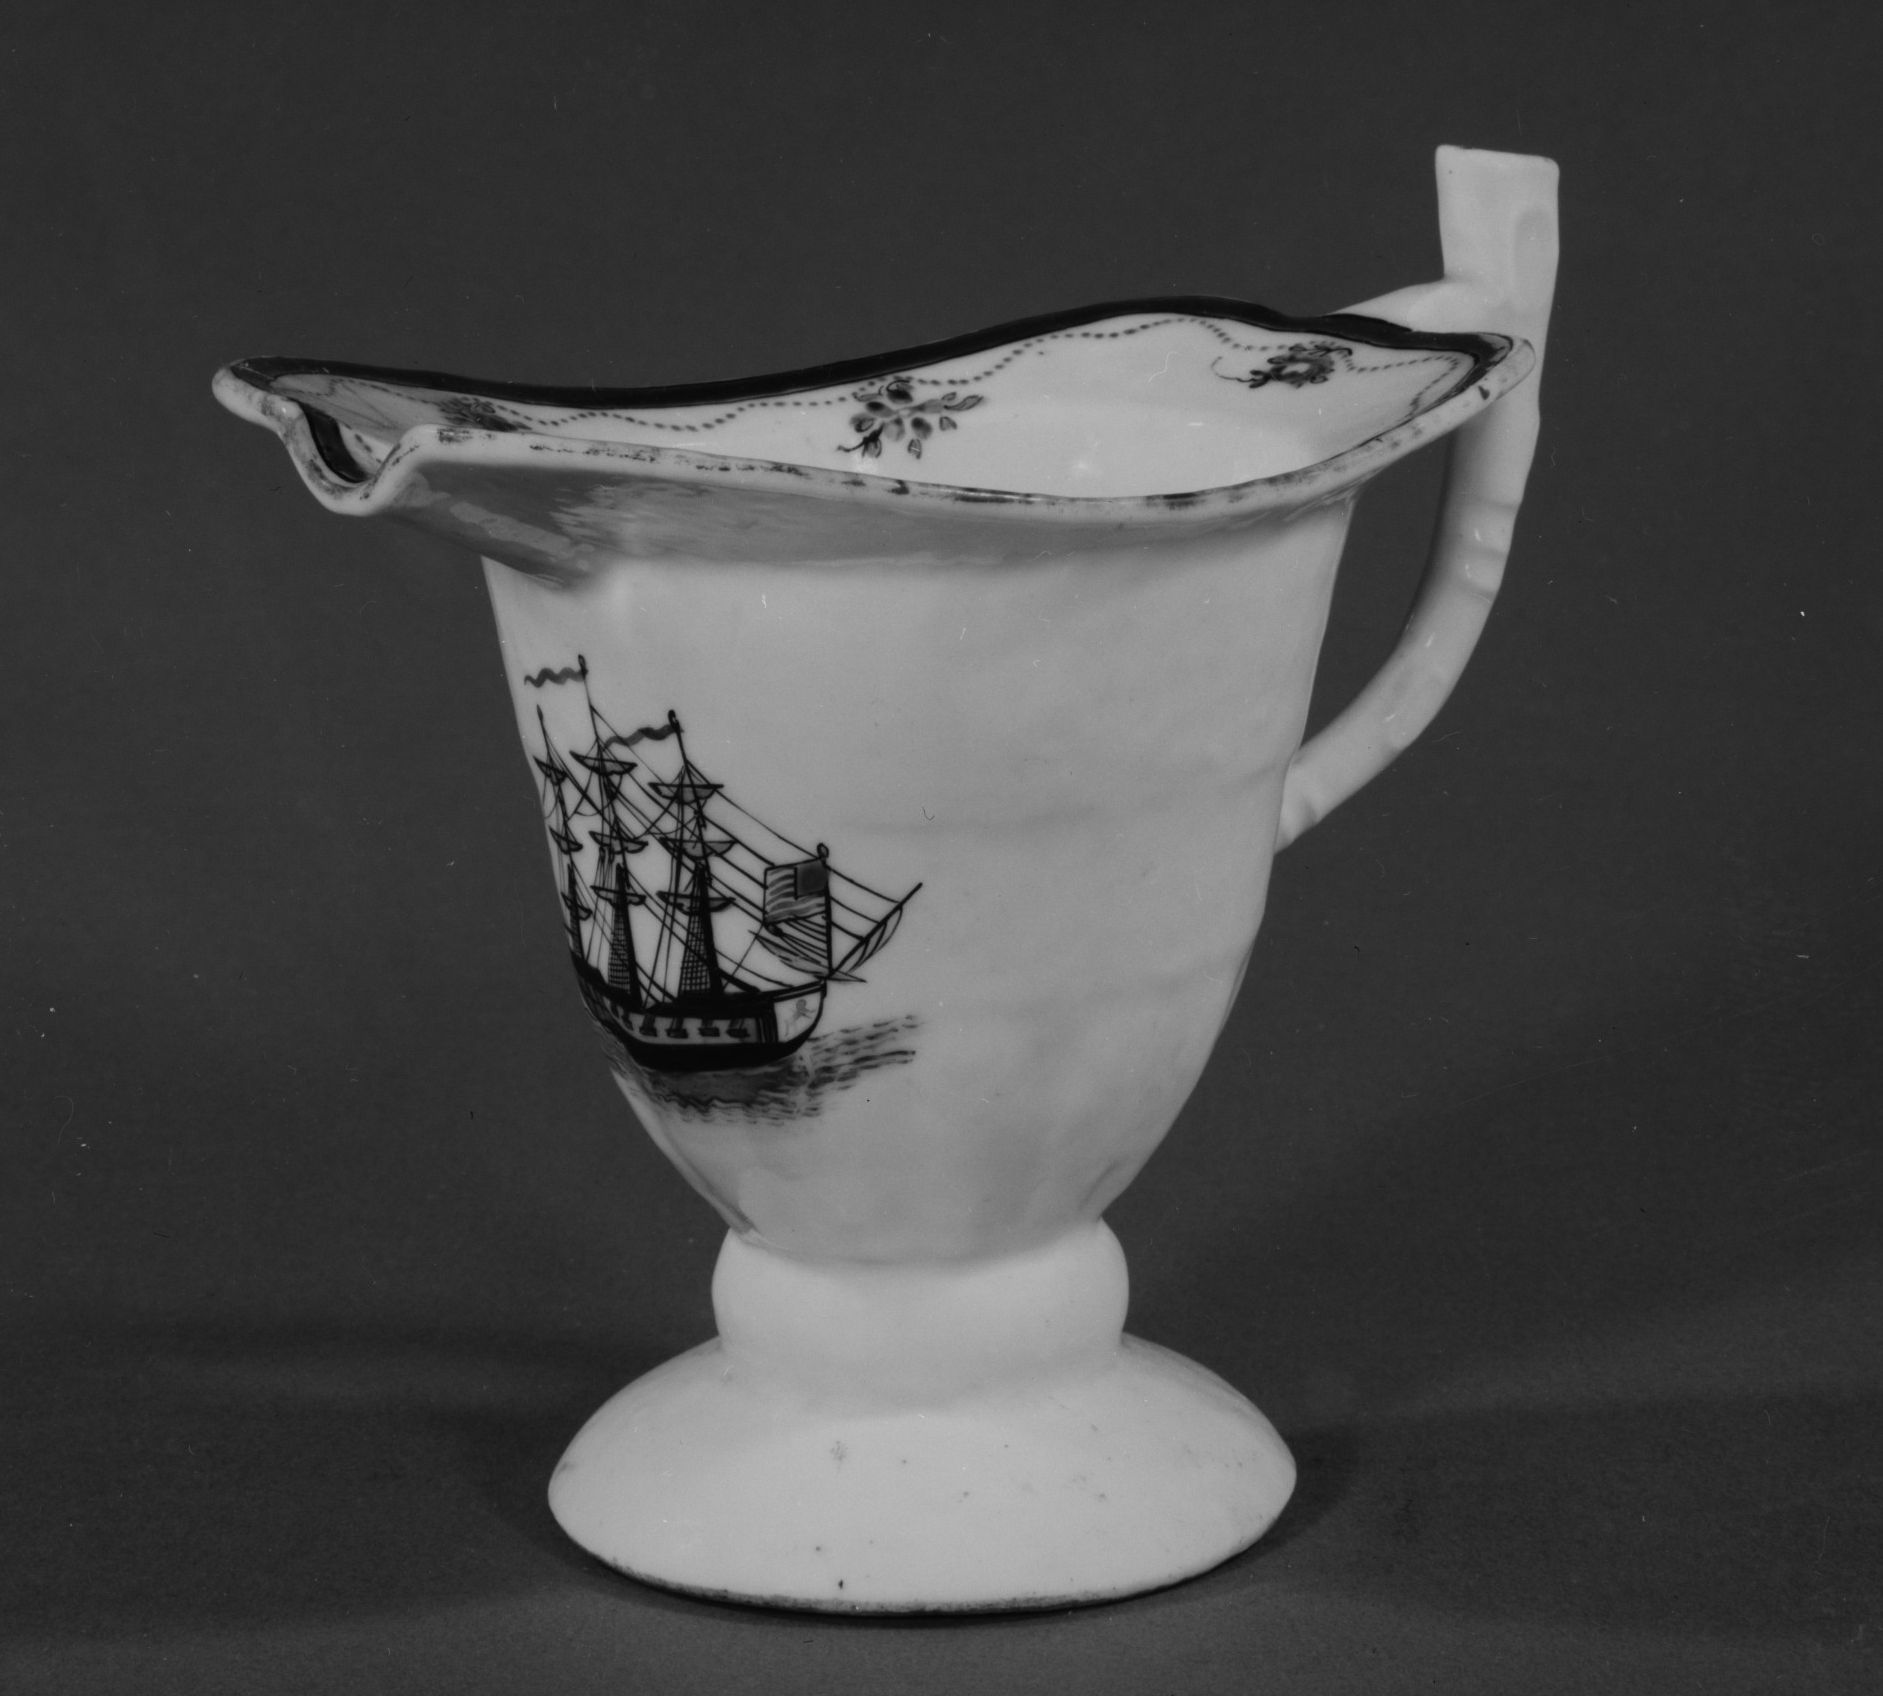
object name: cream pitcher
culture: chinese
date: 1795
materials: porcelain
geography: china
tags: ships